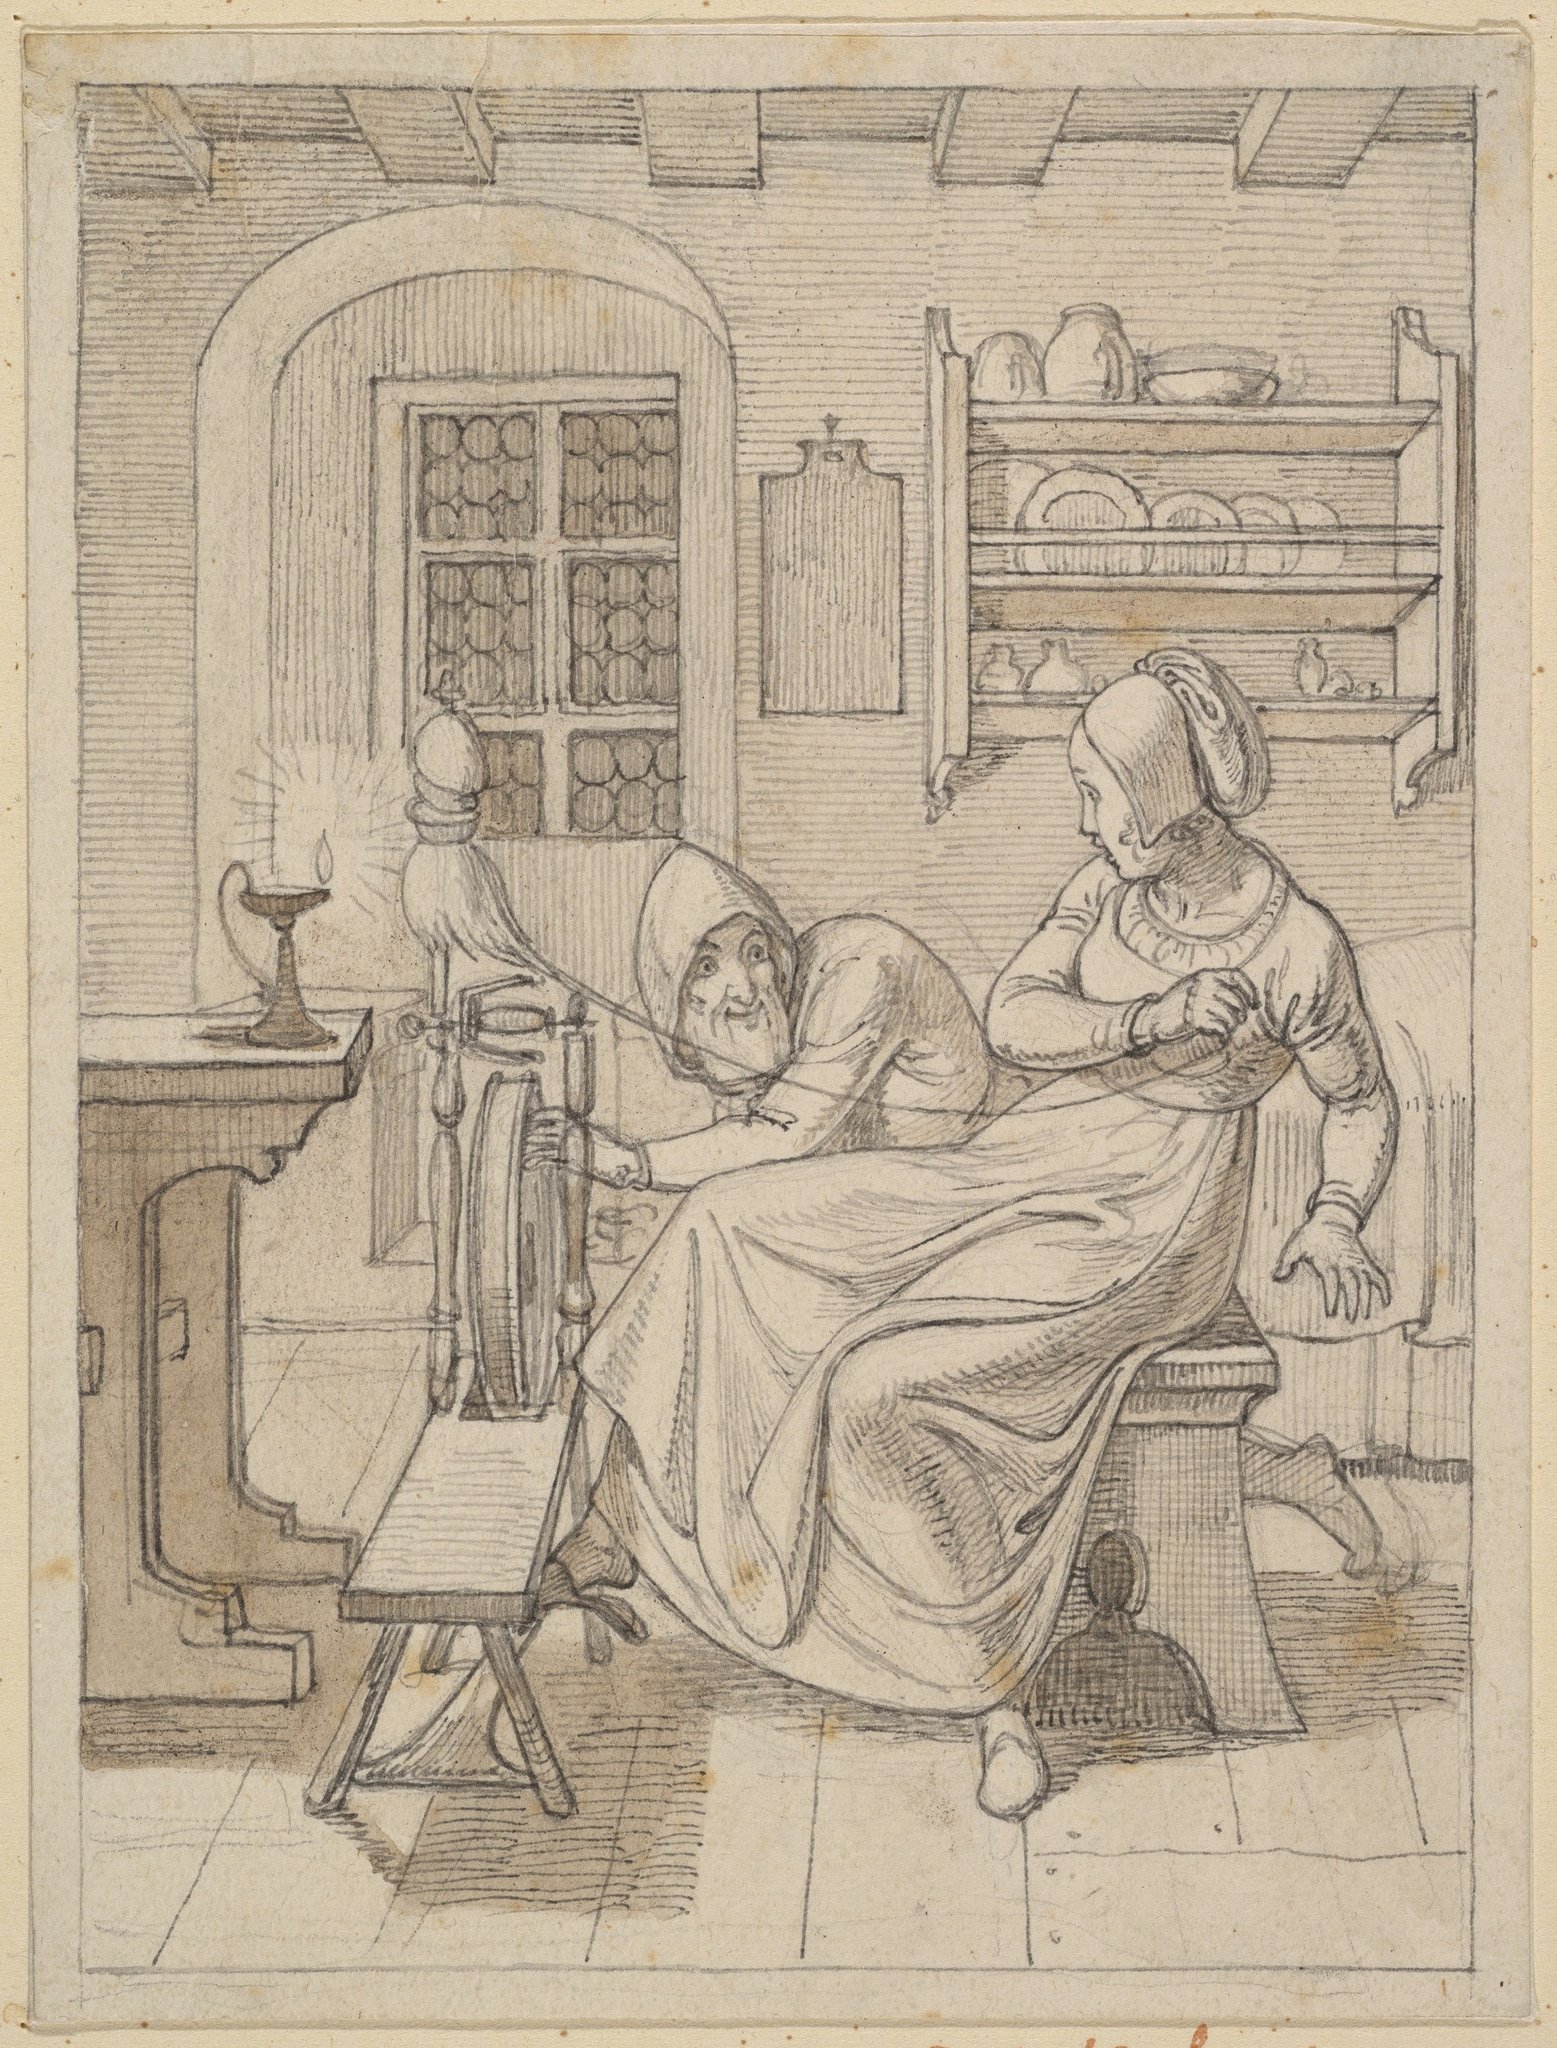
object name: drawing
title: Rumpelstiltskin Appearing to the Miller's Daughter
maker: gustav heinrich naeke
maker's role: artist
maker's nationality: german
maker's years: 1786-1835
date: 1801-1833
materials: graphite, ink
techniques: pen, wash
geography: germany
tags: men,women,working